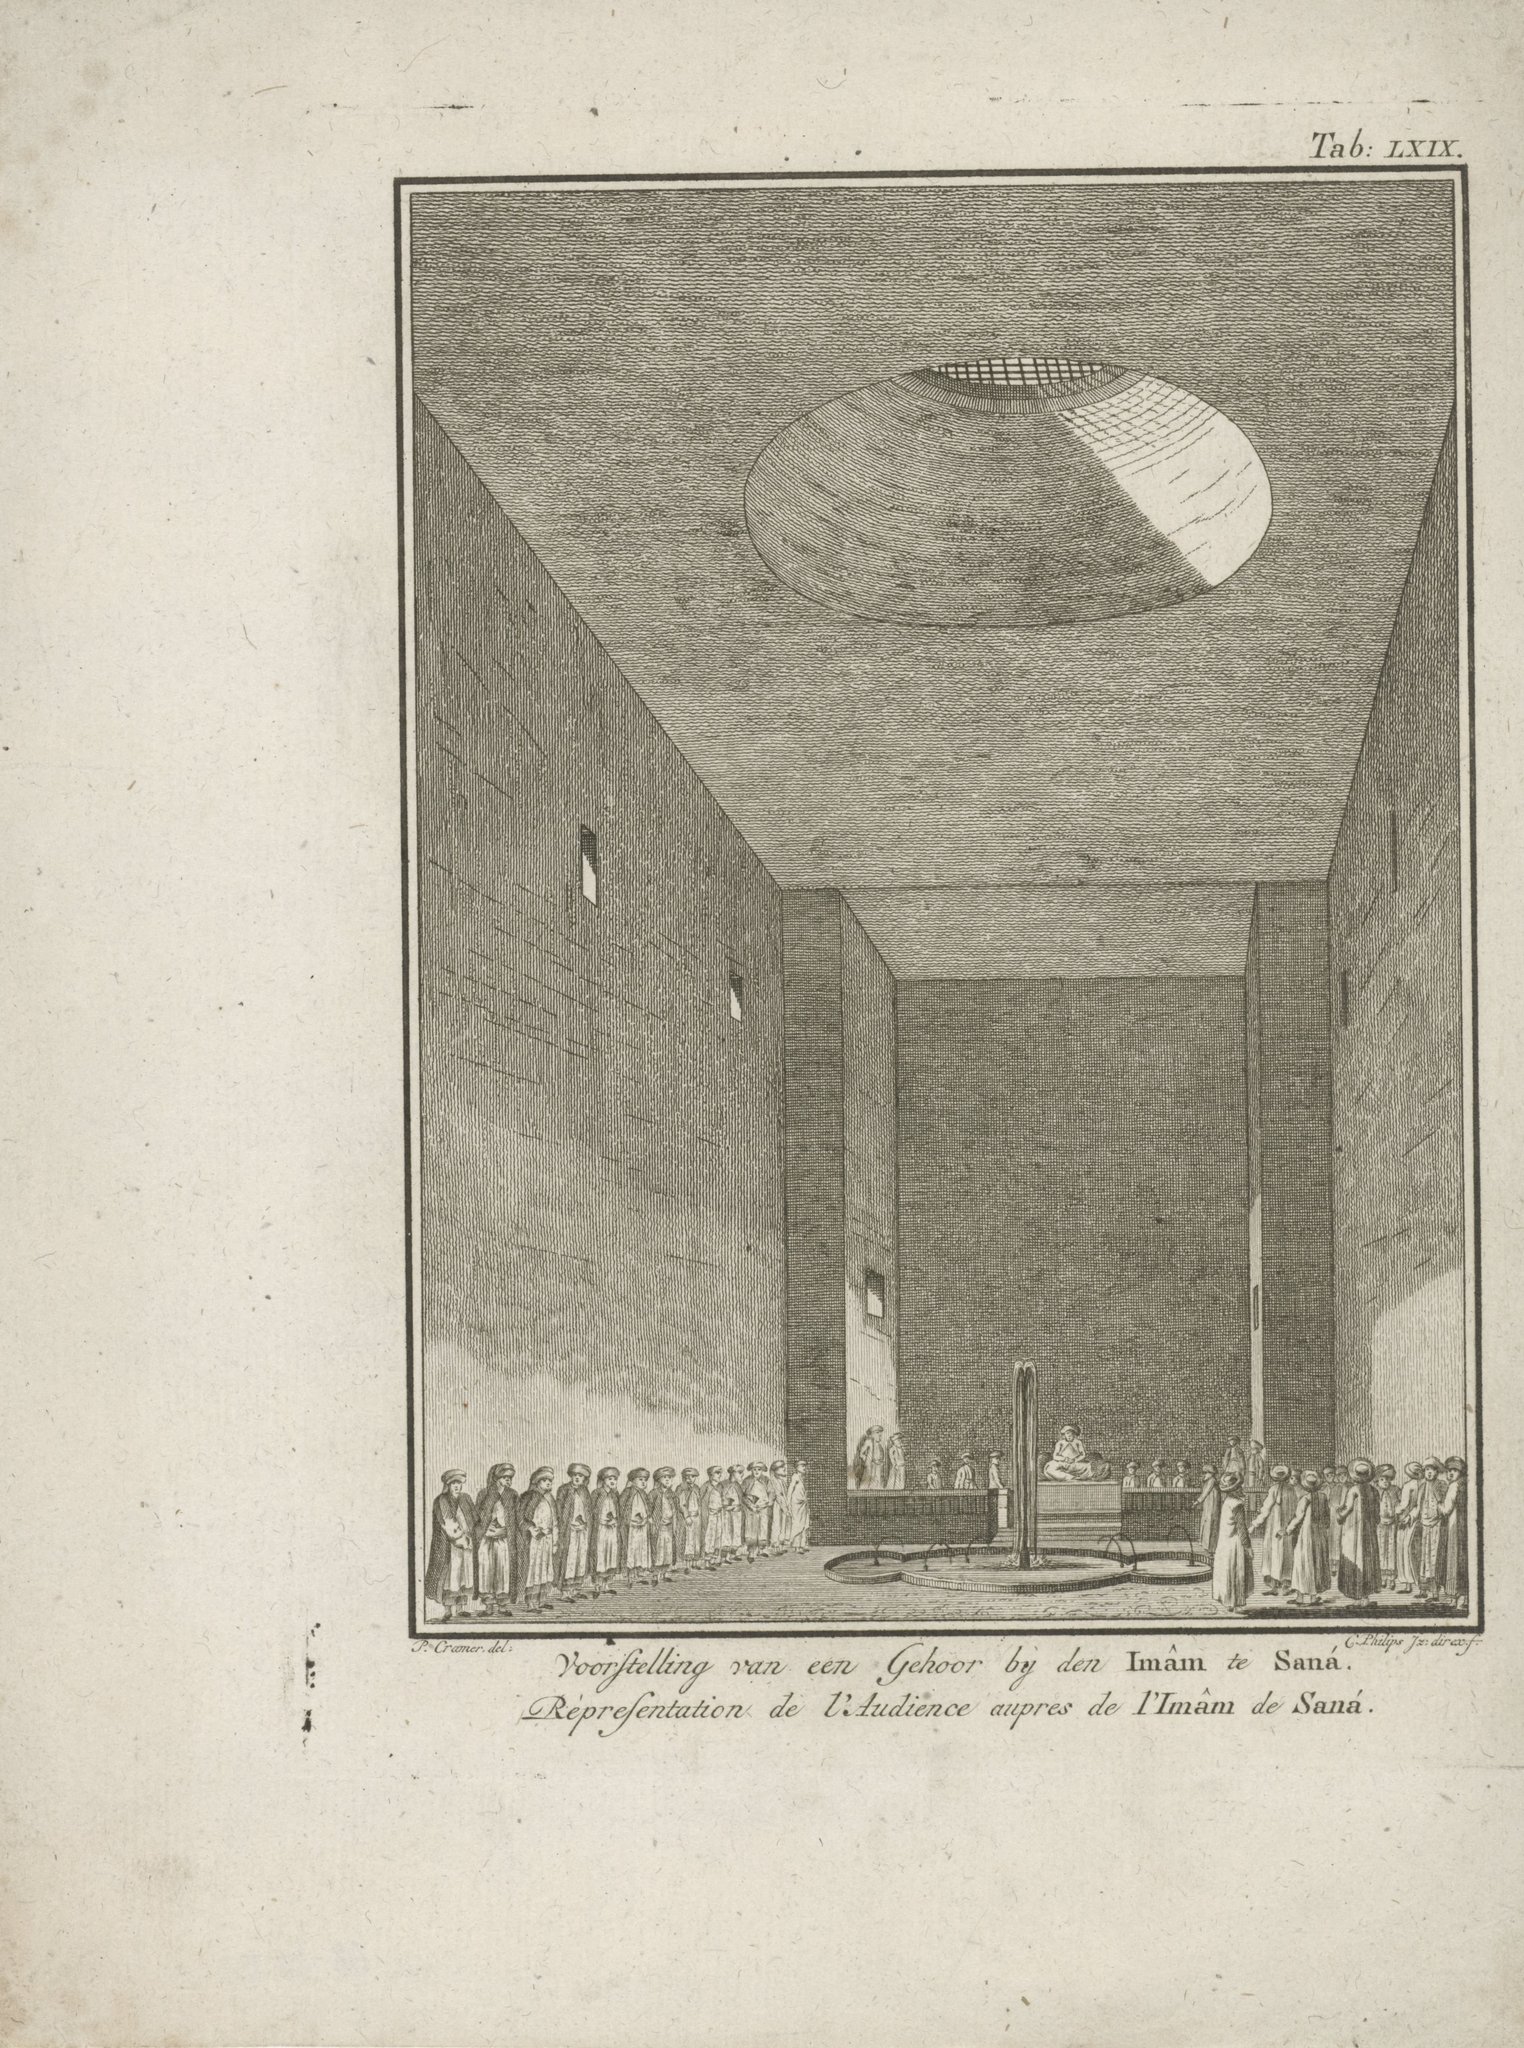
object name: book illustration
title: Voorstelling van een Gehoor by den Imân te Saná / Répresentation de l'Audience aupres de l'Imân de Saná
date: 1776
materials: paper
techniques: etching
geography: amsterdam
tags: priest ~ islam, mohammedanism, temple, shrine ~ islam, mohammedanism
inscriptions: collector's mark: Lugt 2228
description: Prent gebruikt in: Niebuhr, Carsten en Ferdinand Louis Mourier, Voyage en Arabie & en d'autres pays circonvoisins, deel I. Amsterdam: S. J. Baalde, 1776.